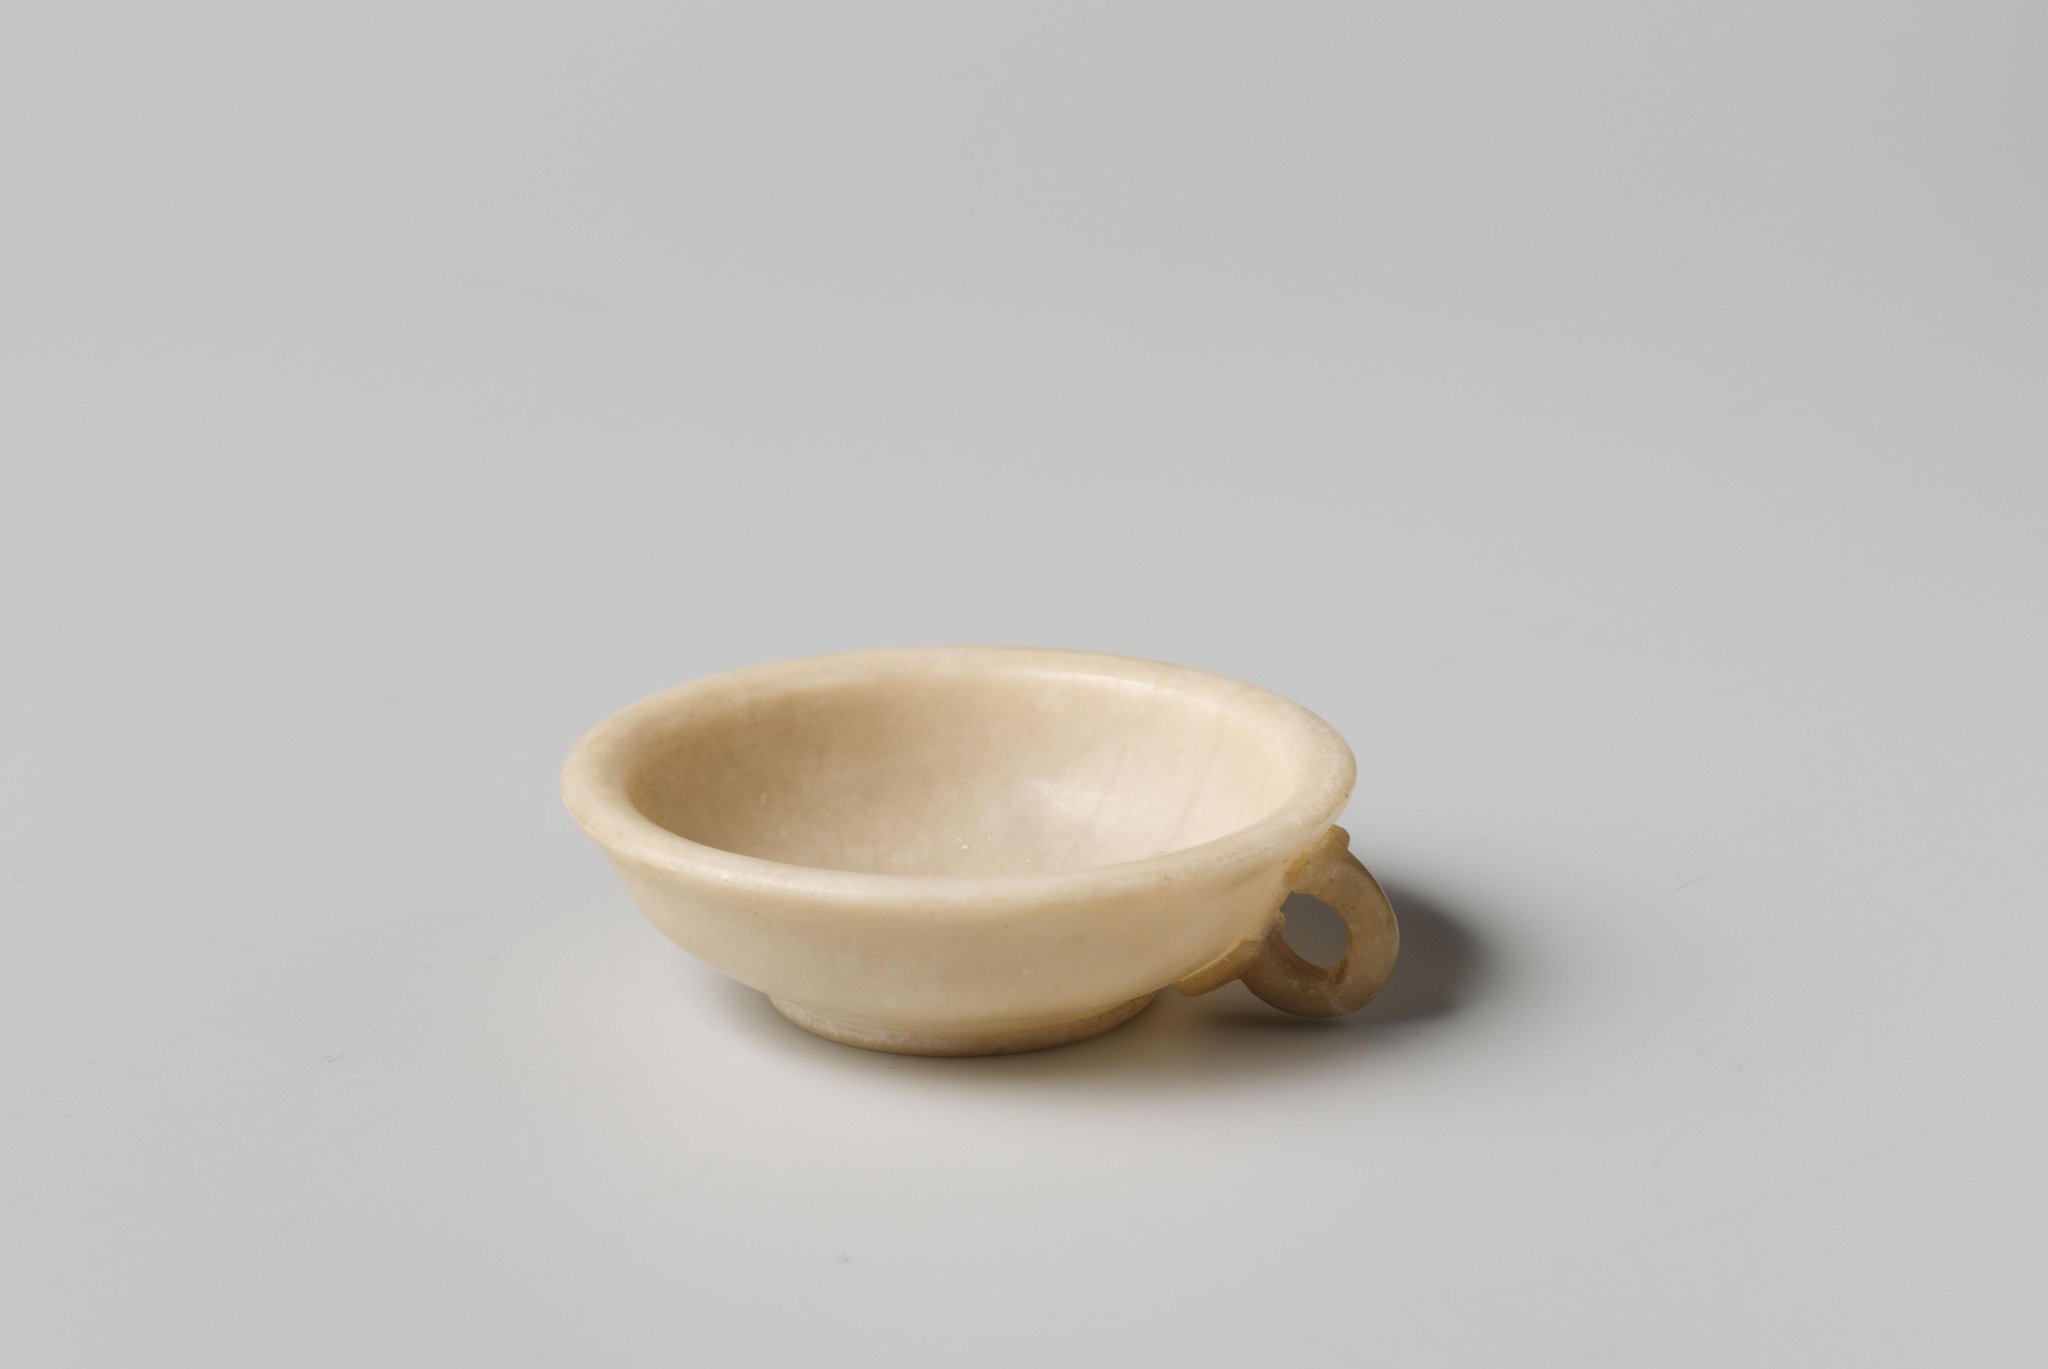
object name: miniature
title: Schaal van albast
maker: Anonymous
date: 1650-1699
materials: alabaster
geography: netherlands